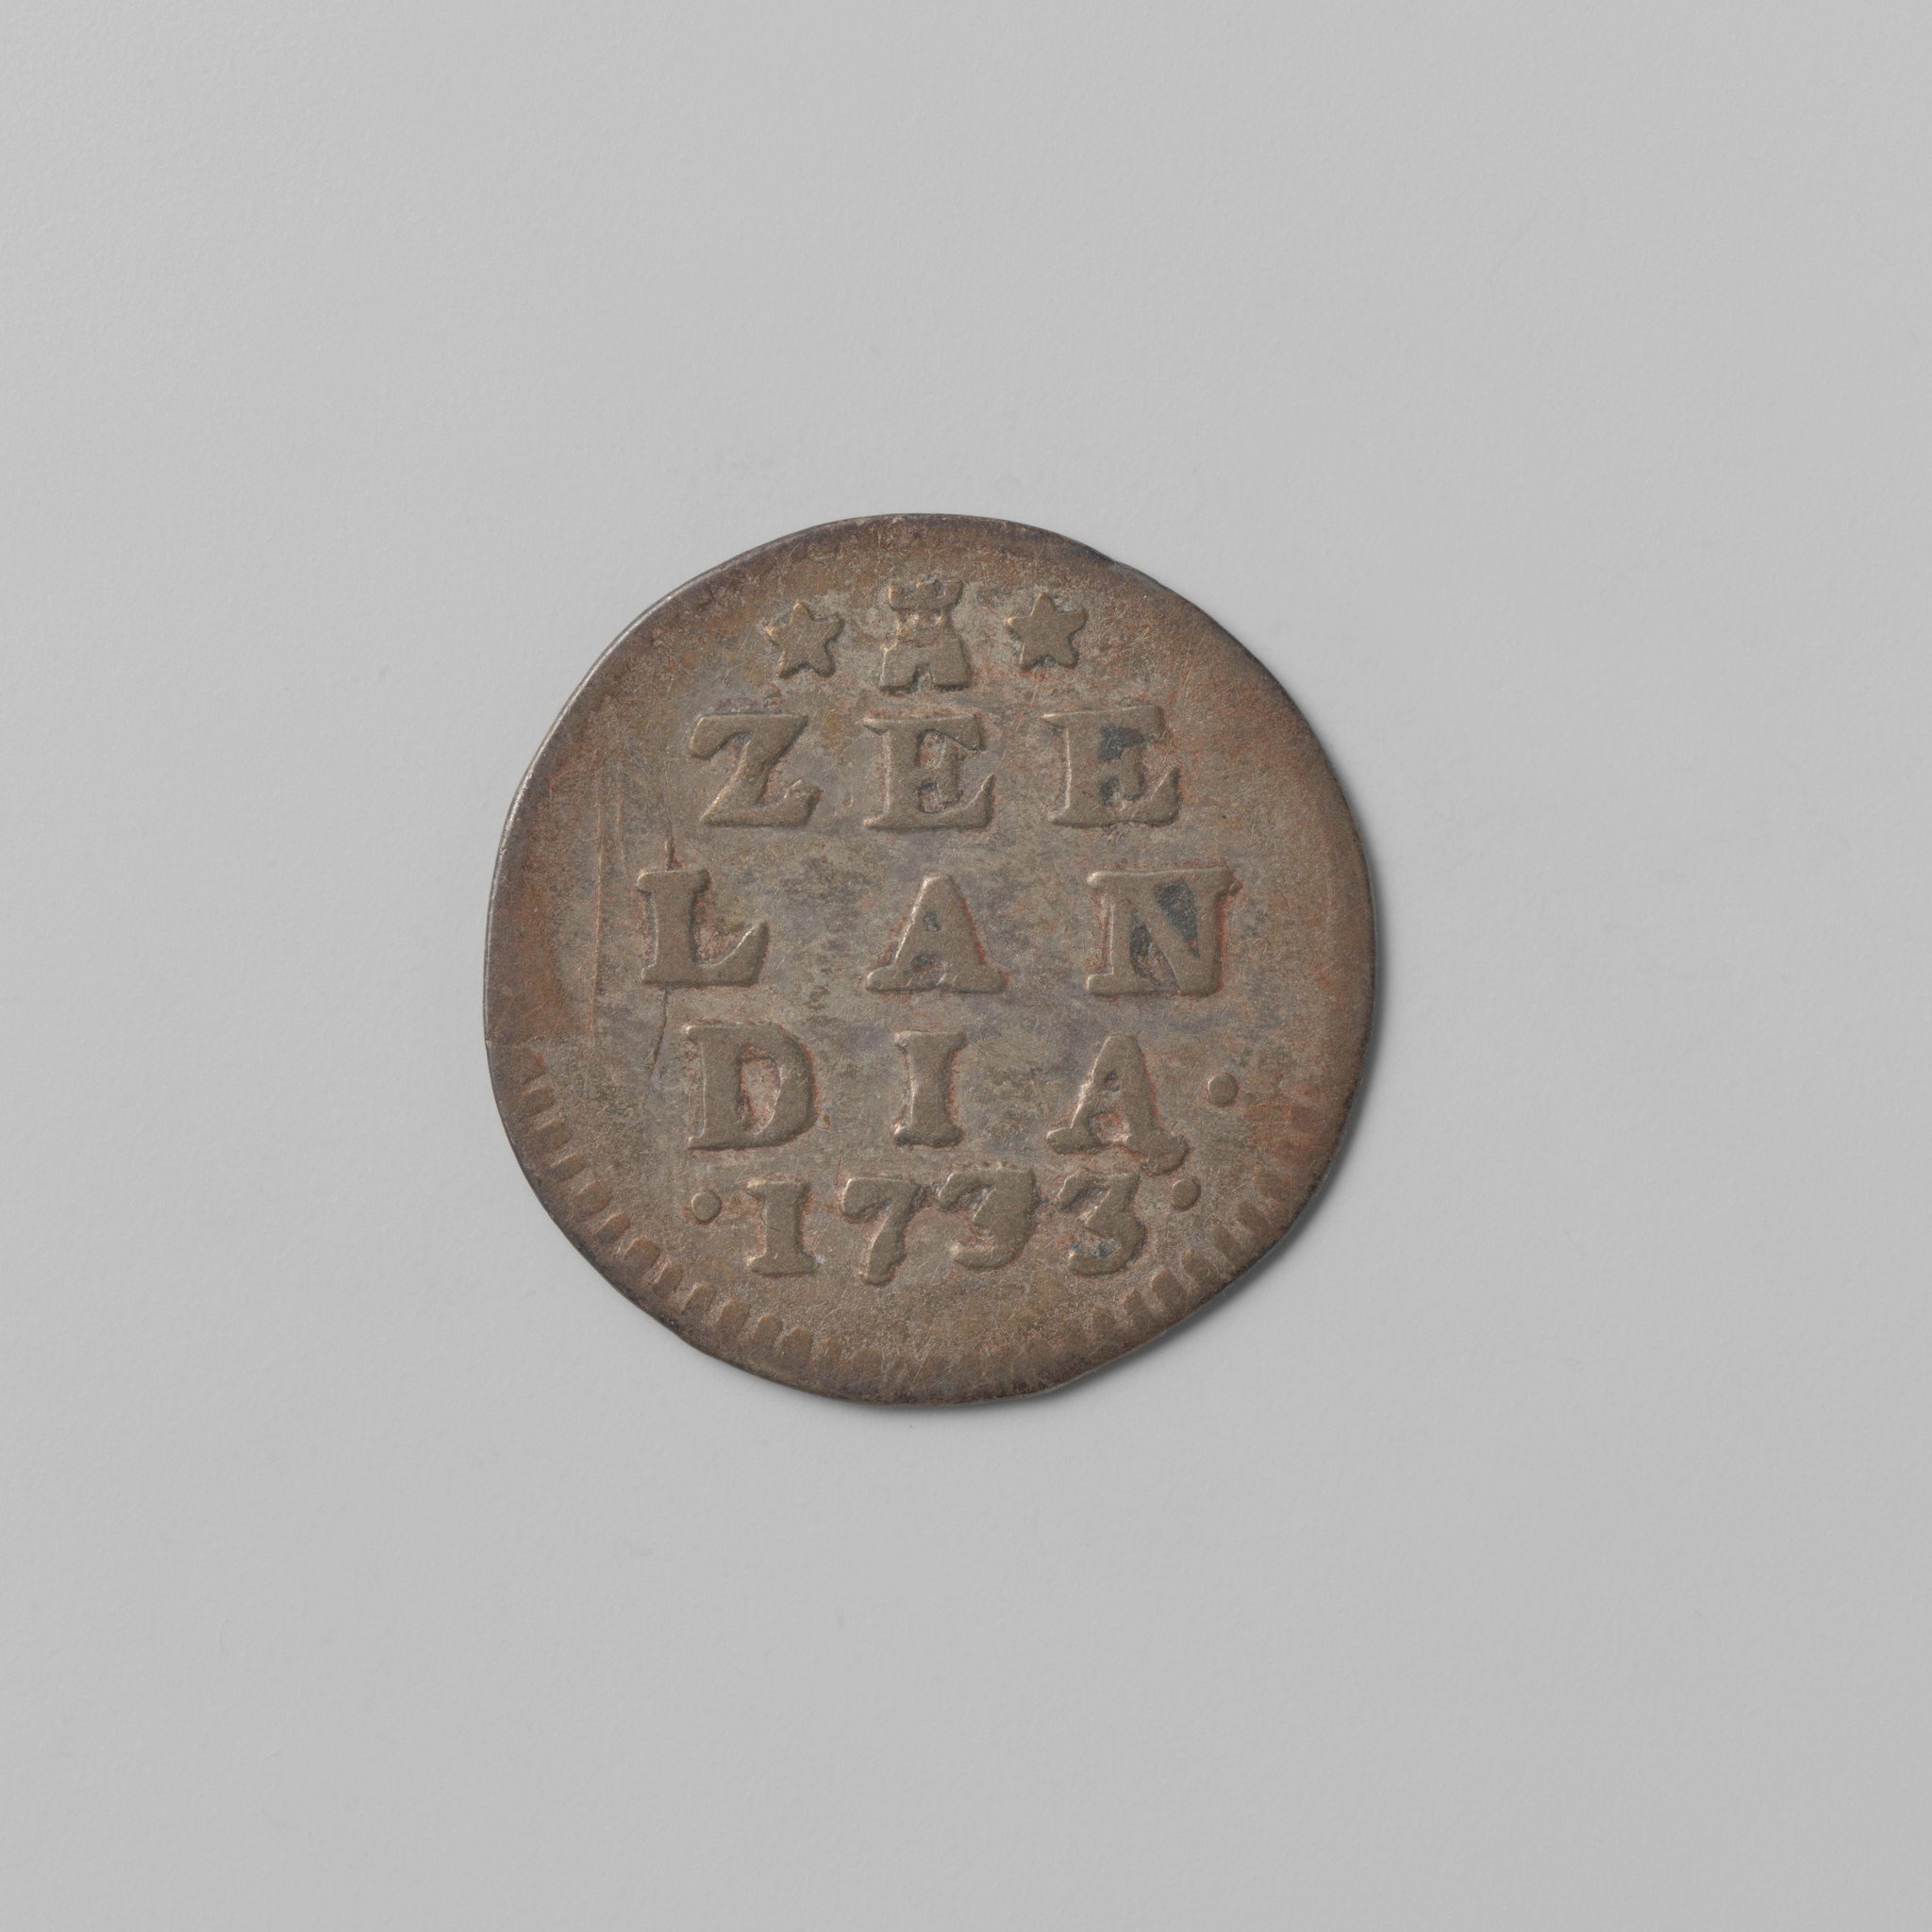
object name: coin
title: Zeeuwse dubbele stuiver, 1733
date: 1733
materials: silver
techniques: striking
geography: middelburg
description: Zilveren munt. Voorzijde: tussen waarde-aanduiding 2 S gekroond wapenschild van Zeeland. Keerzijde: opschrift in drie regels, waarboven muntteken burcht tussen twee rozetten en waaronder jaartal.